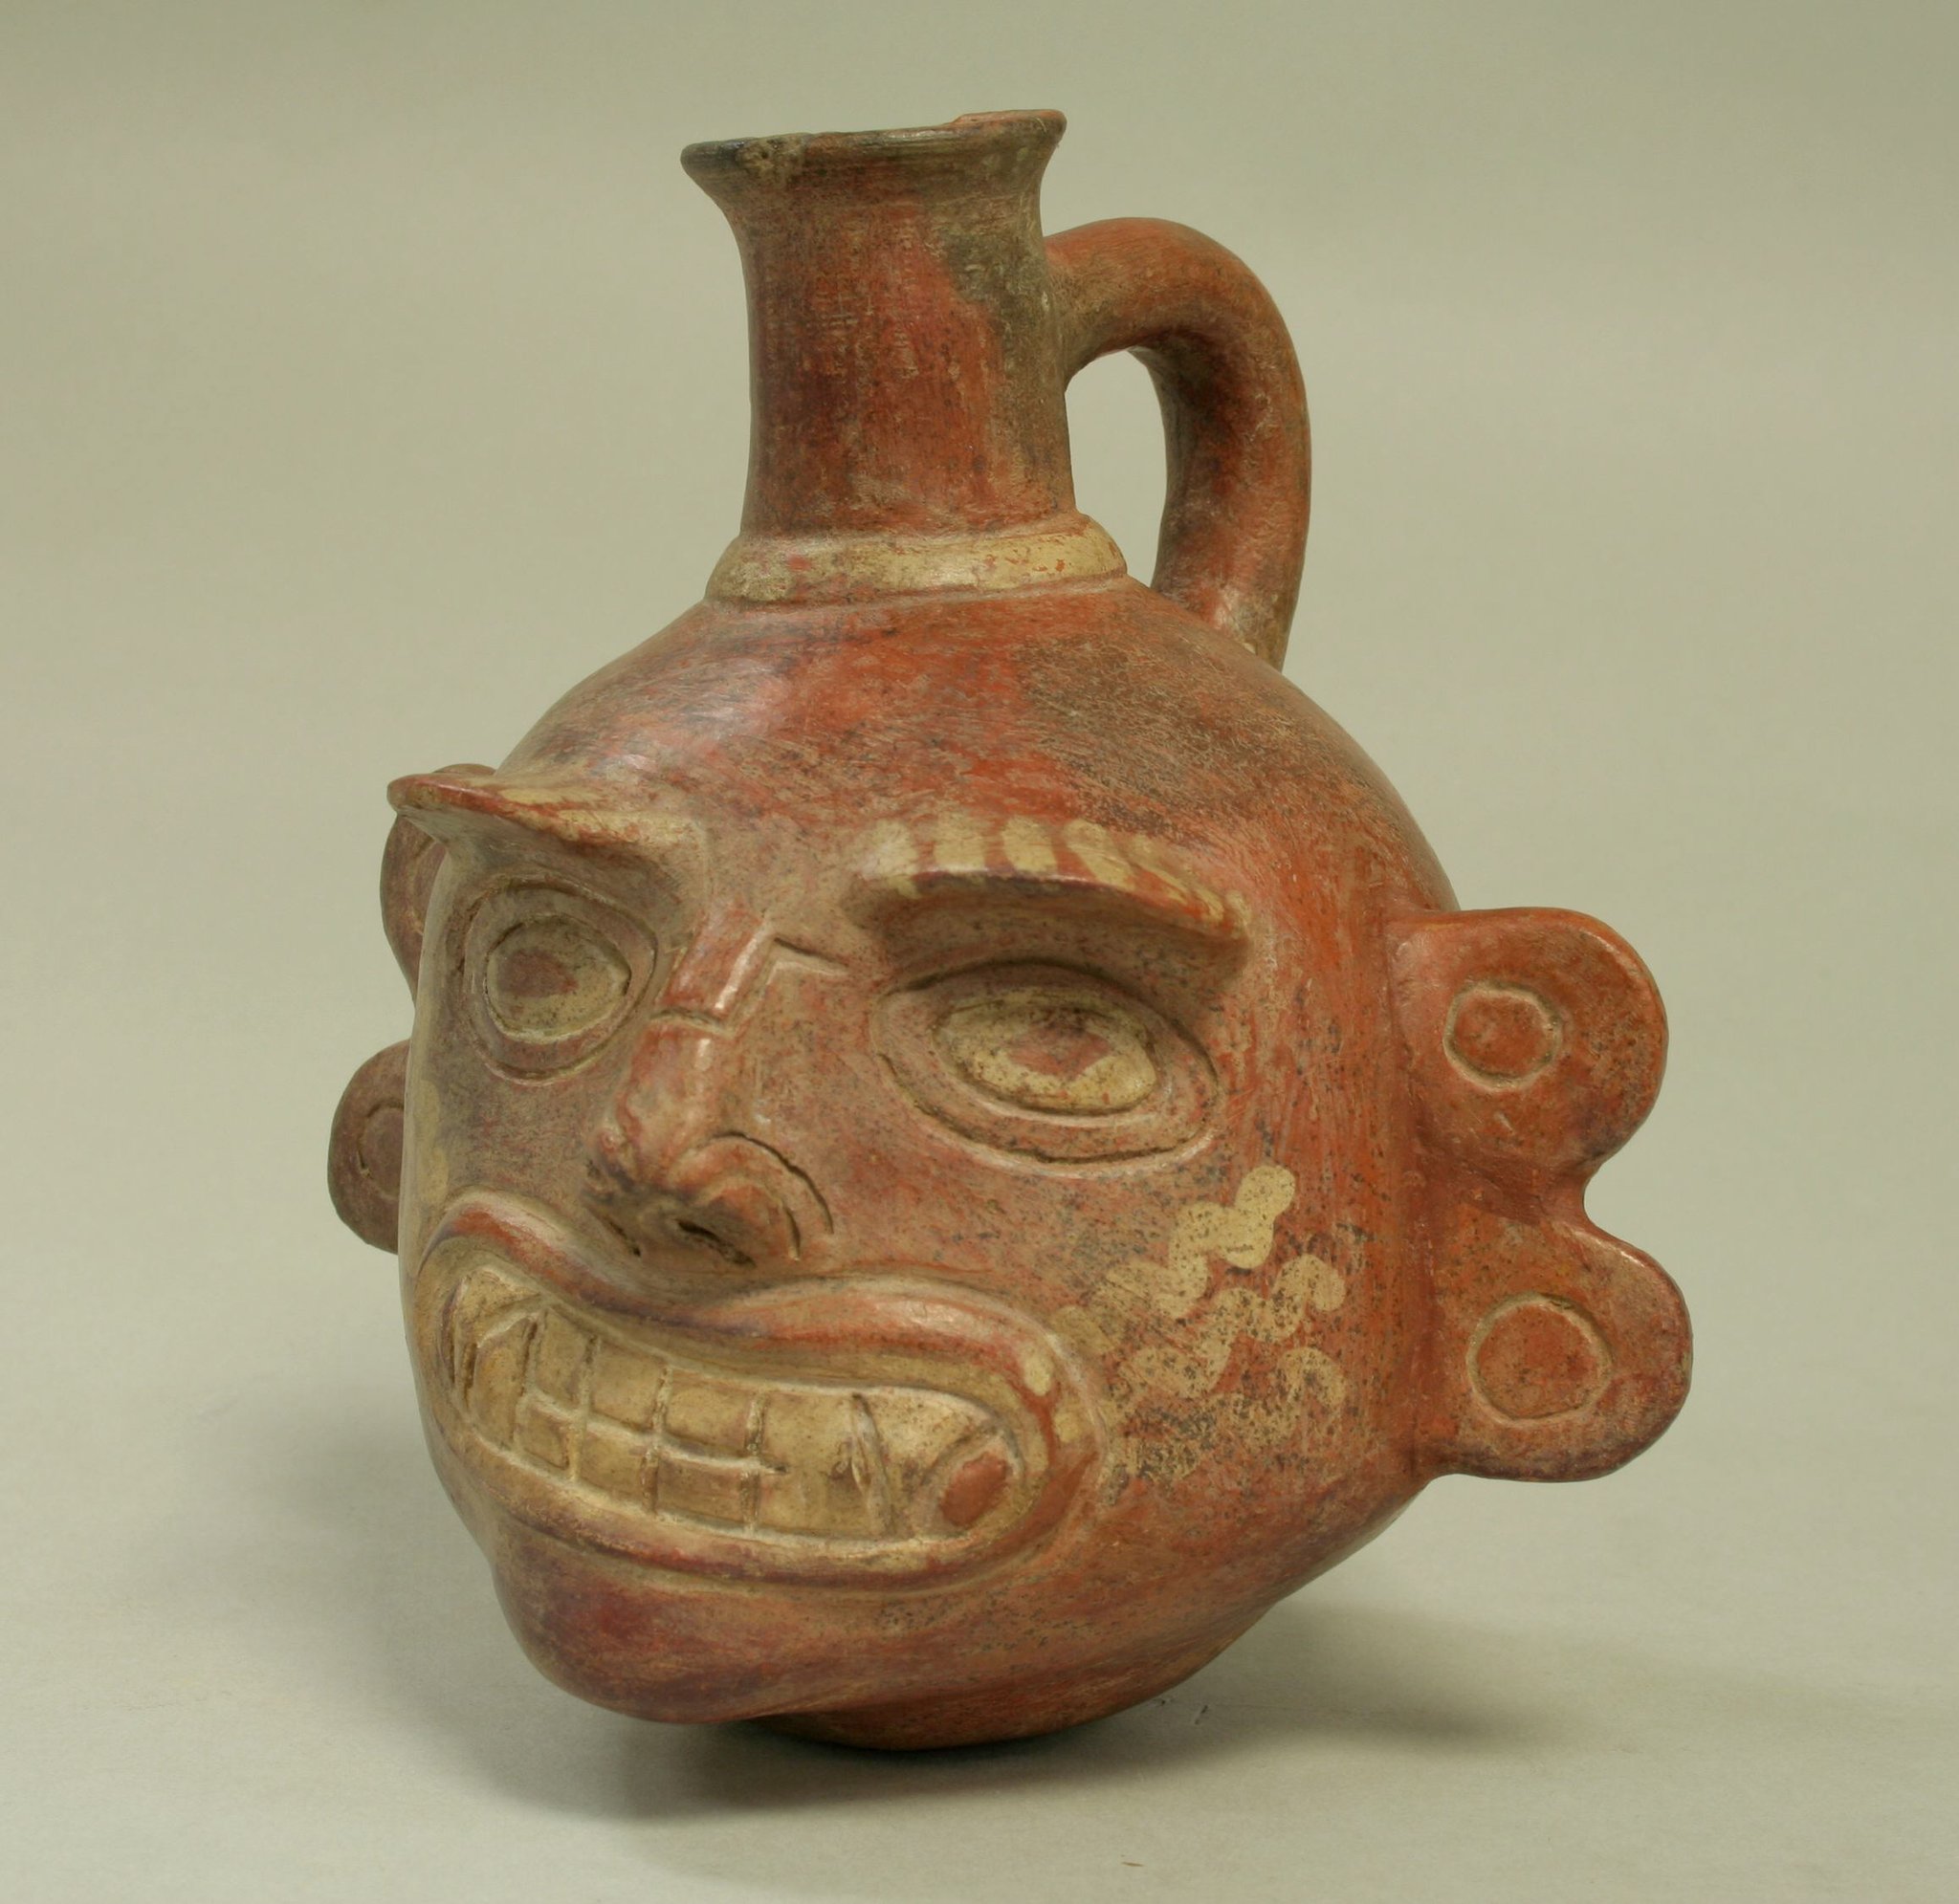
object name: bottle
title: Single Spout Bottle with Fanged Face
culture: vicús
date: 300 BCE-200 CE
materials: ceramic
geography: peru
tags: faces